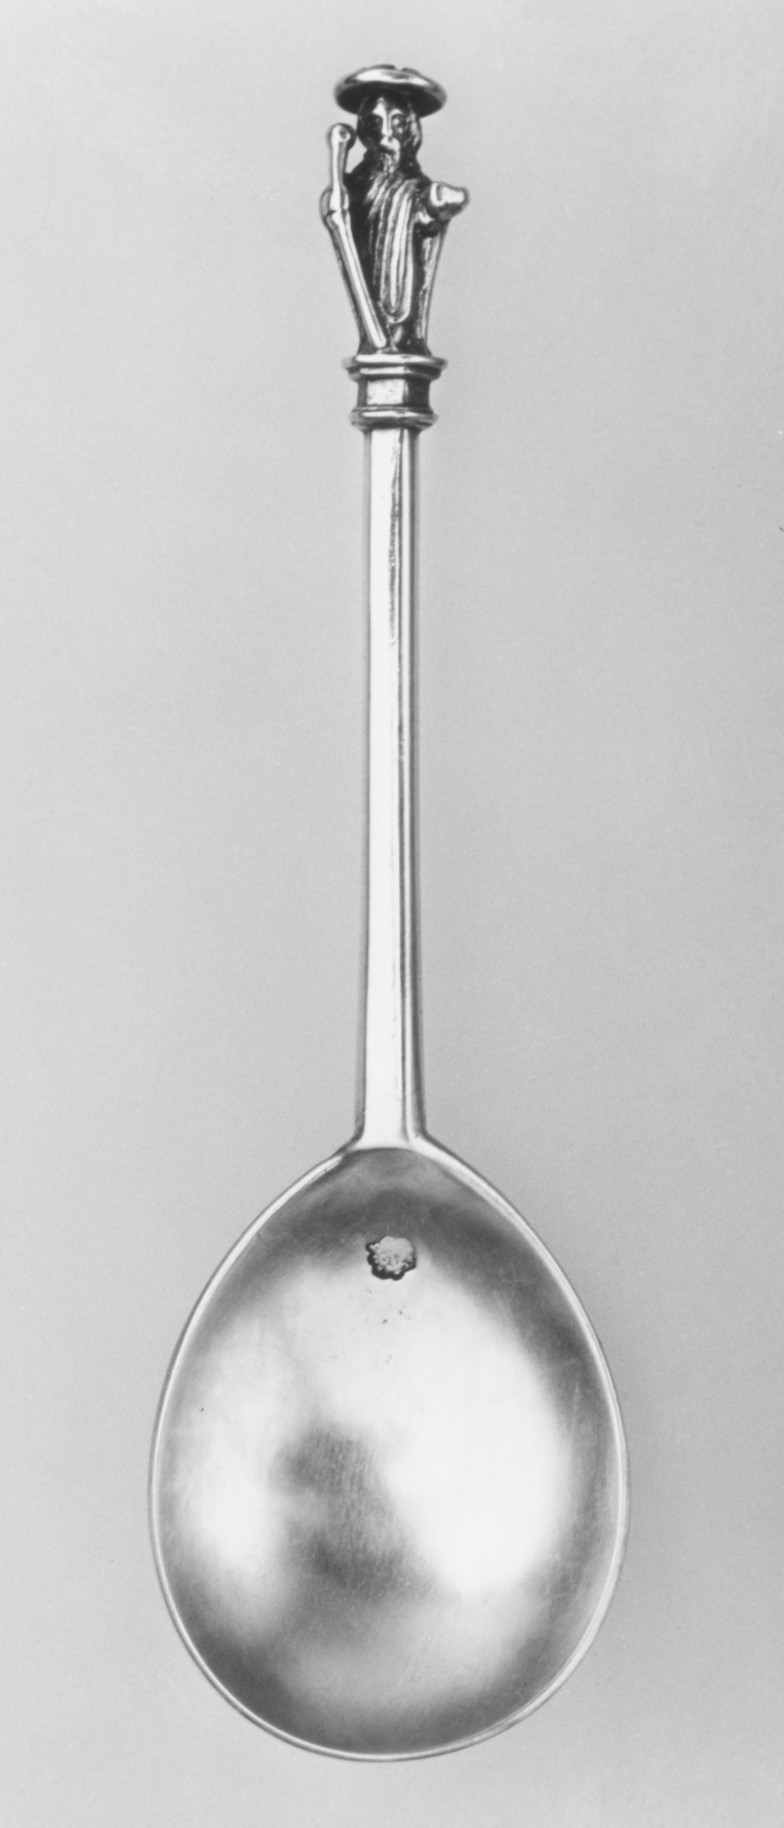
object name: apostle spoon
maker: john foxe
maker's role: maker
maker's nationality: british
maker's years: 1546-1597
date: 1565-1566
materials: gilt, silver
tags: men